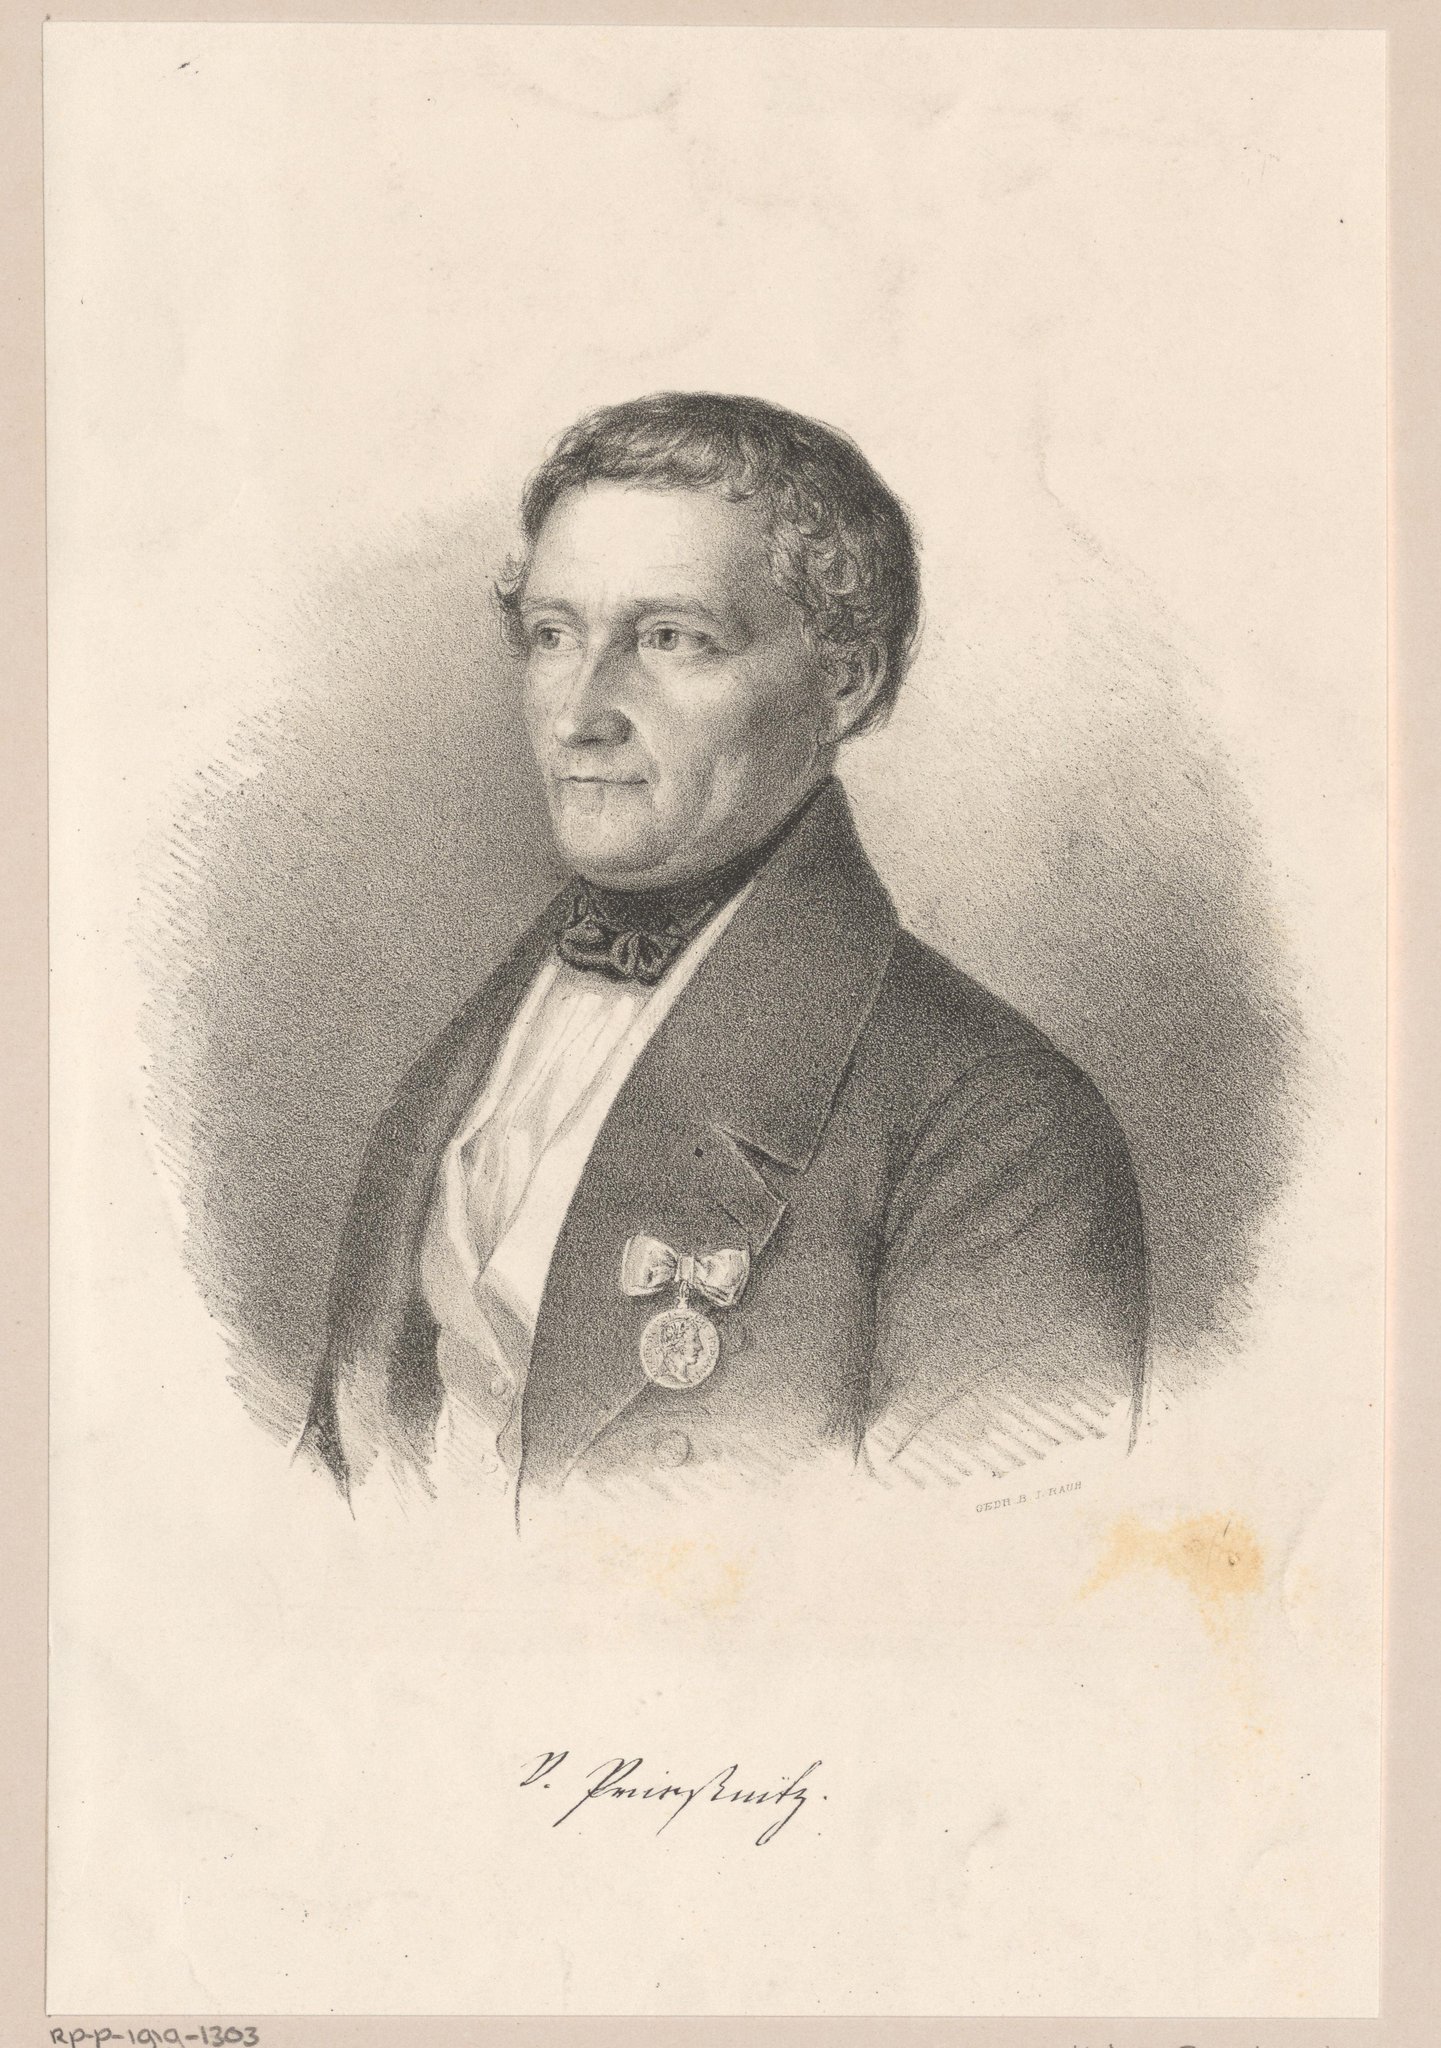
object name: print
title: Portret van Vincent Priessnitz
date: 1839-1863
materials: paper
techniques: lithograph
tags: historical persons, physician, doctor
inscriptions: collector's mark: Lugt 2228